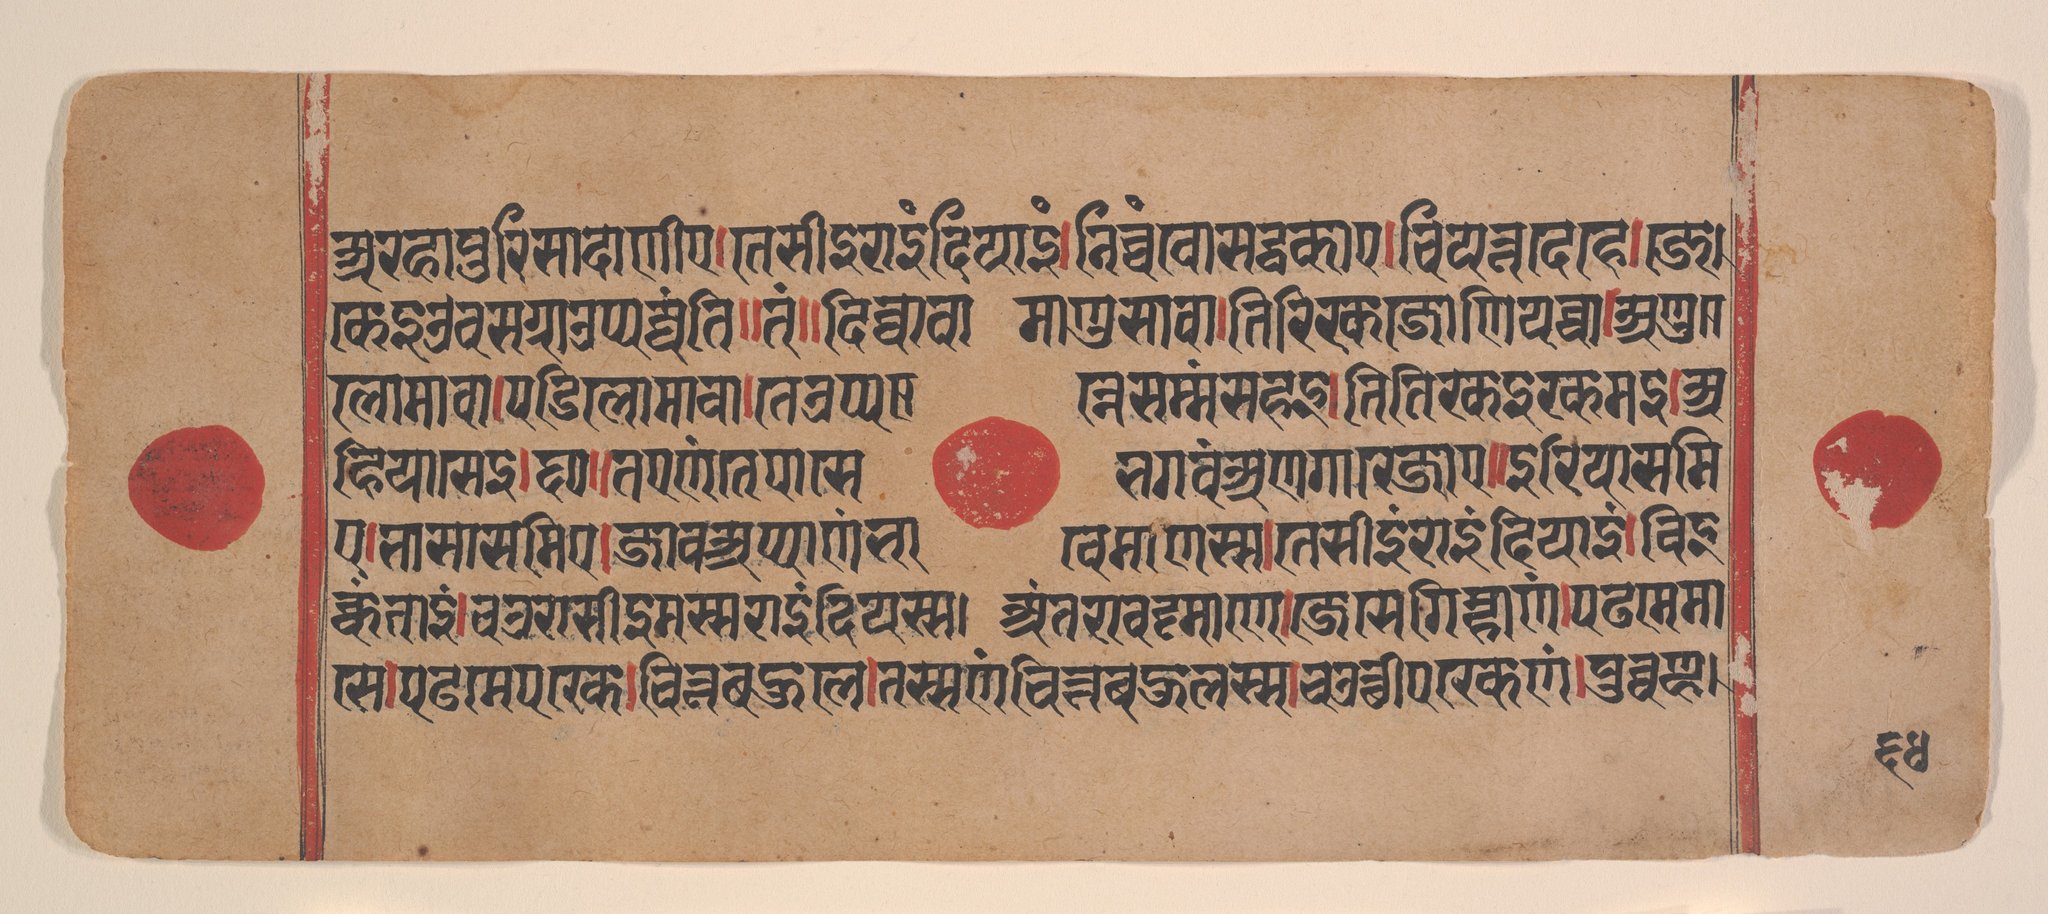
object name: folio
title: Page from a Dispersed Kalpa Sutra (Jain Book of Rituals)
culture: indian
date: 1401-1500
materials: gold, ink, paper, watercolor